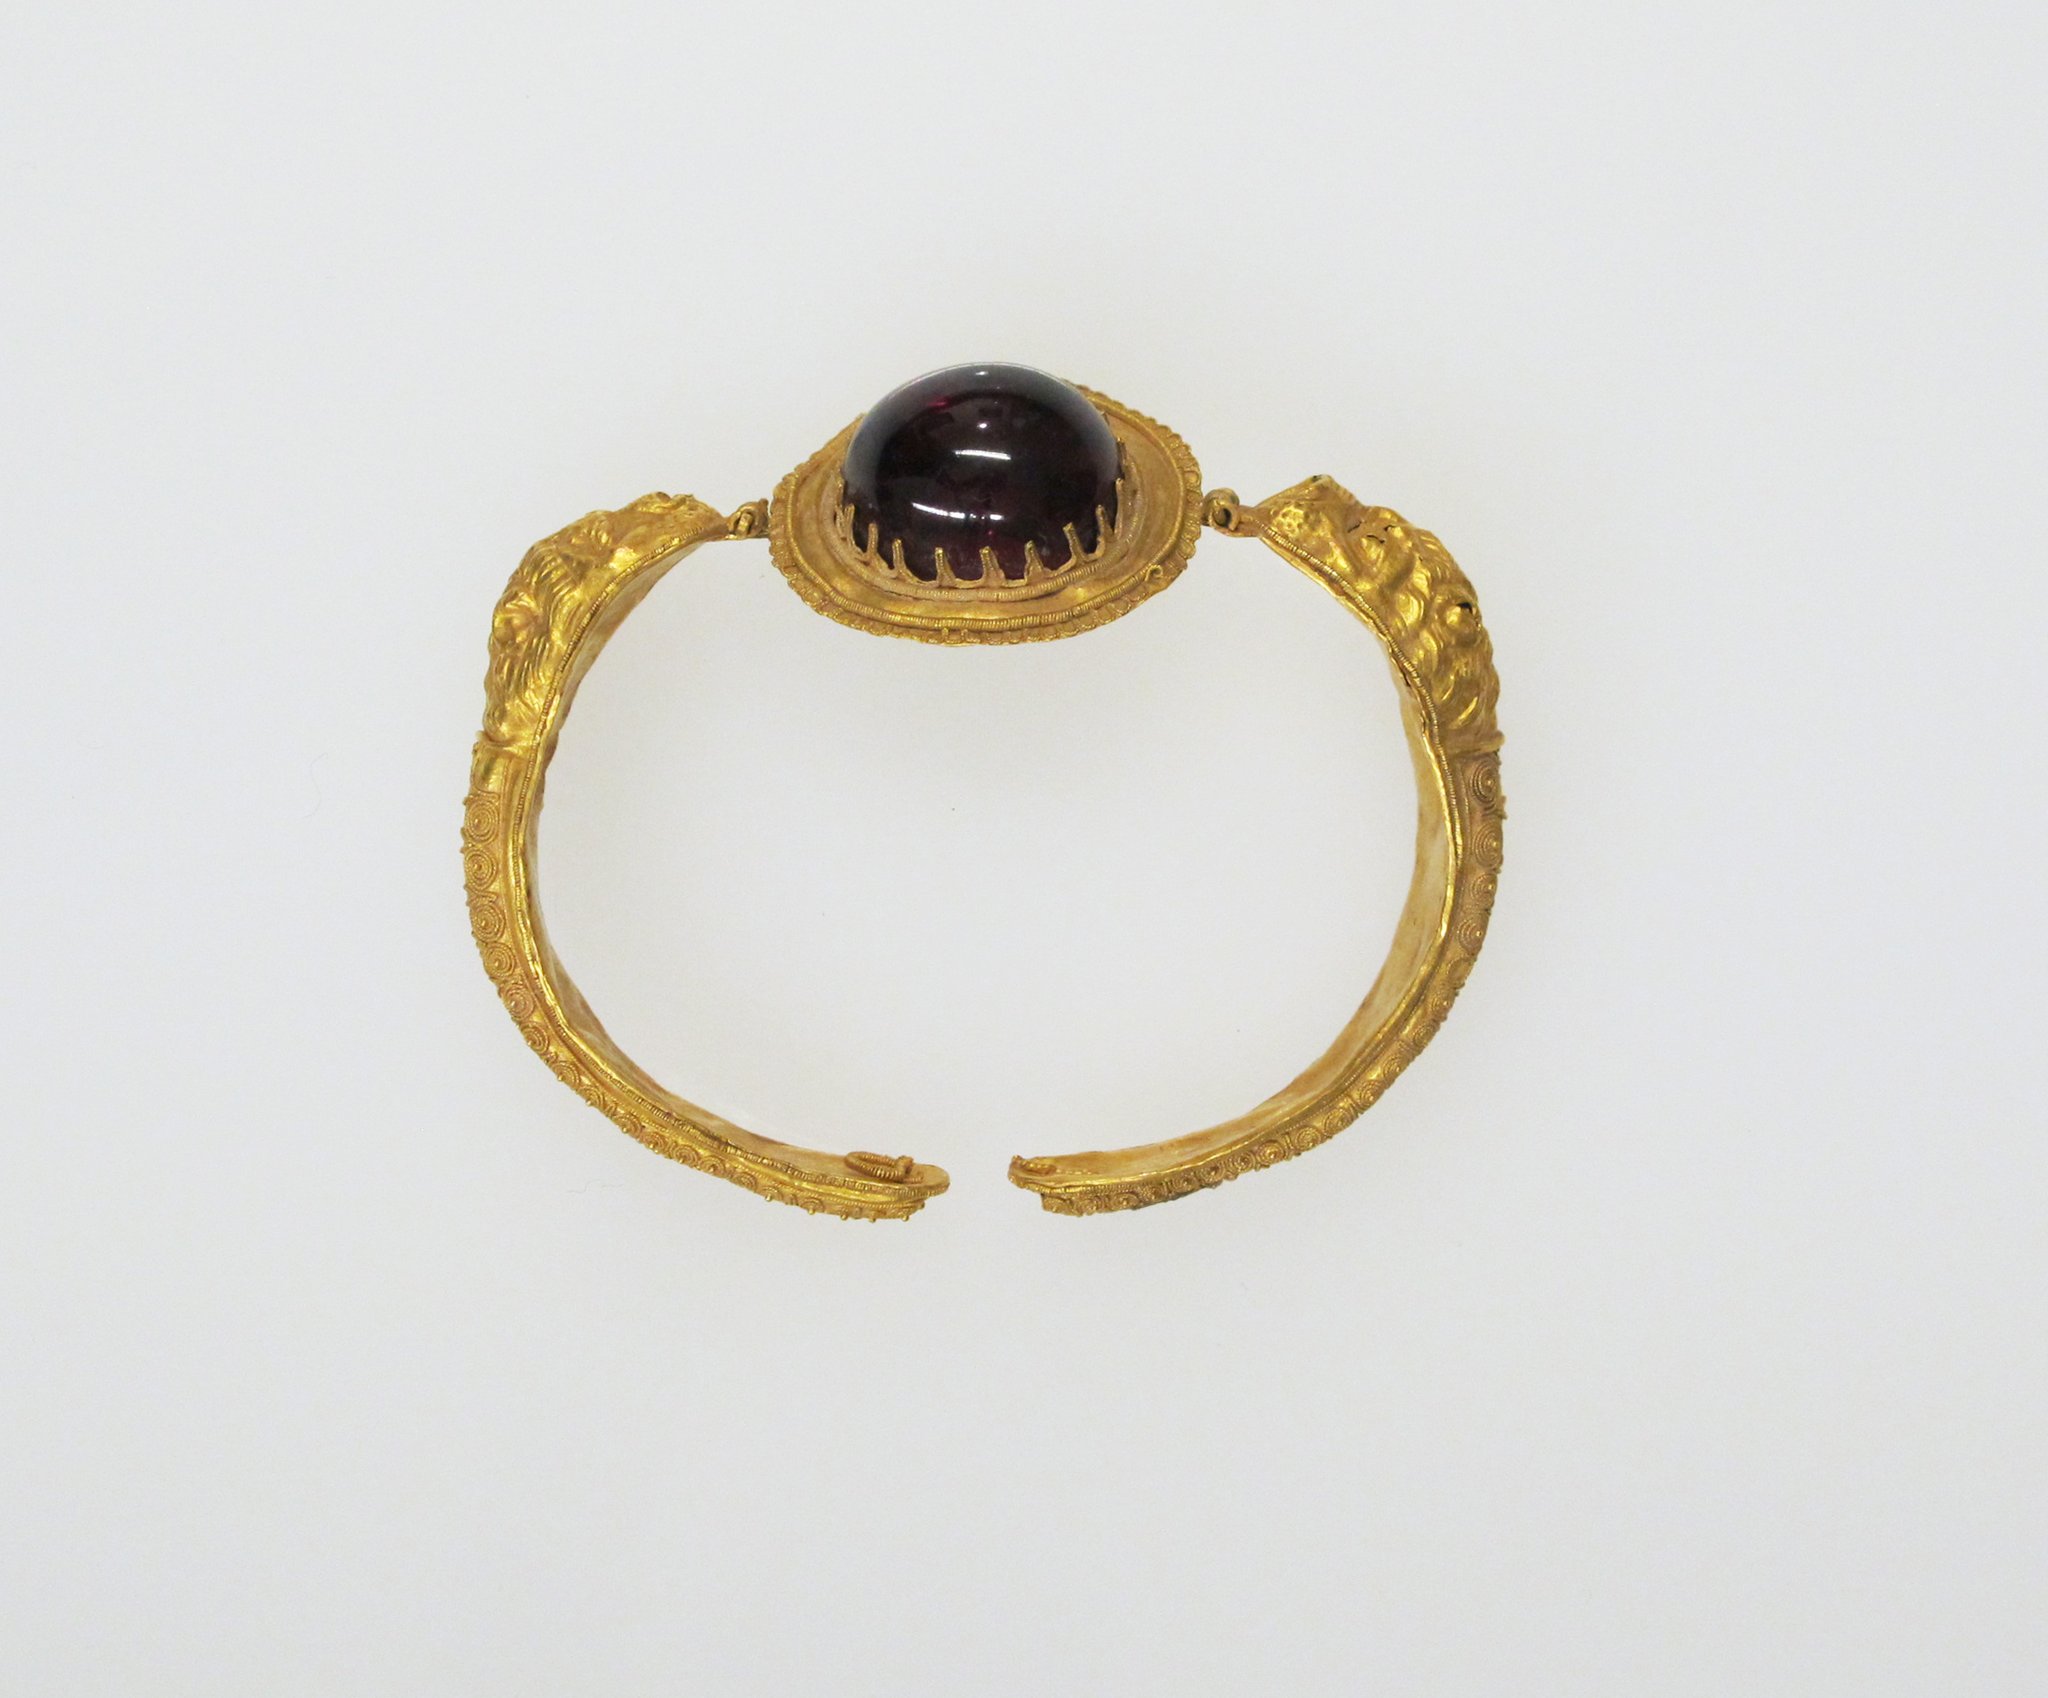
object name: bracelet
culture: greek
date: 400-301 BCE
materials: gold